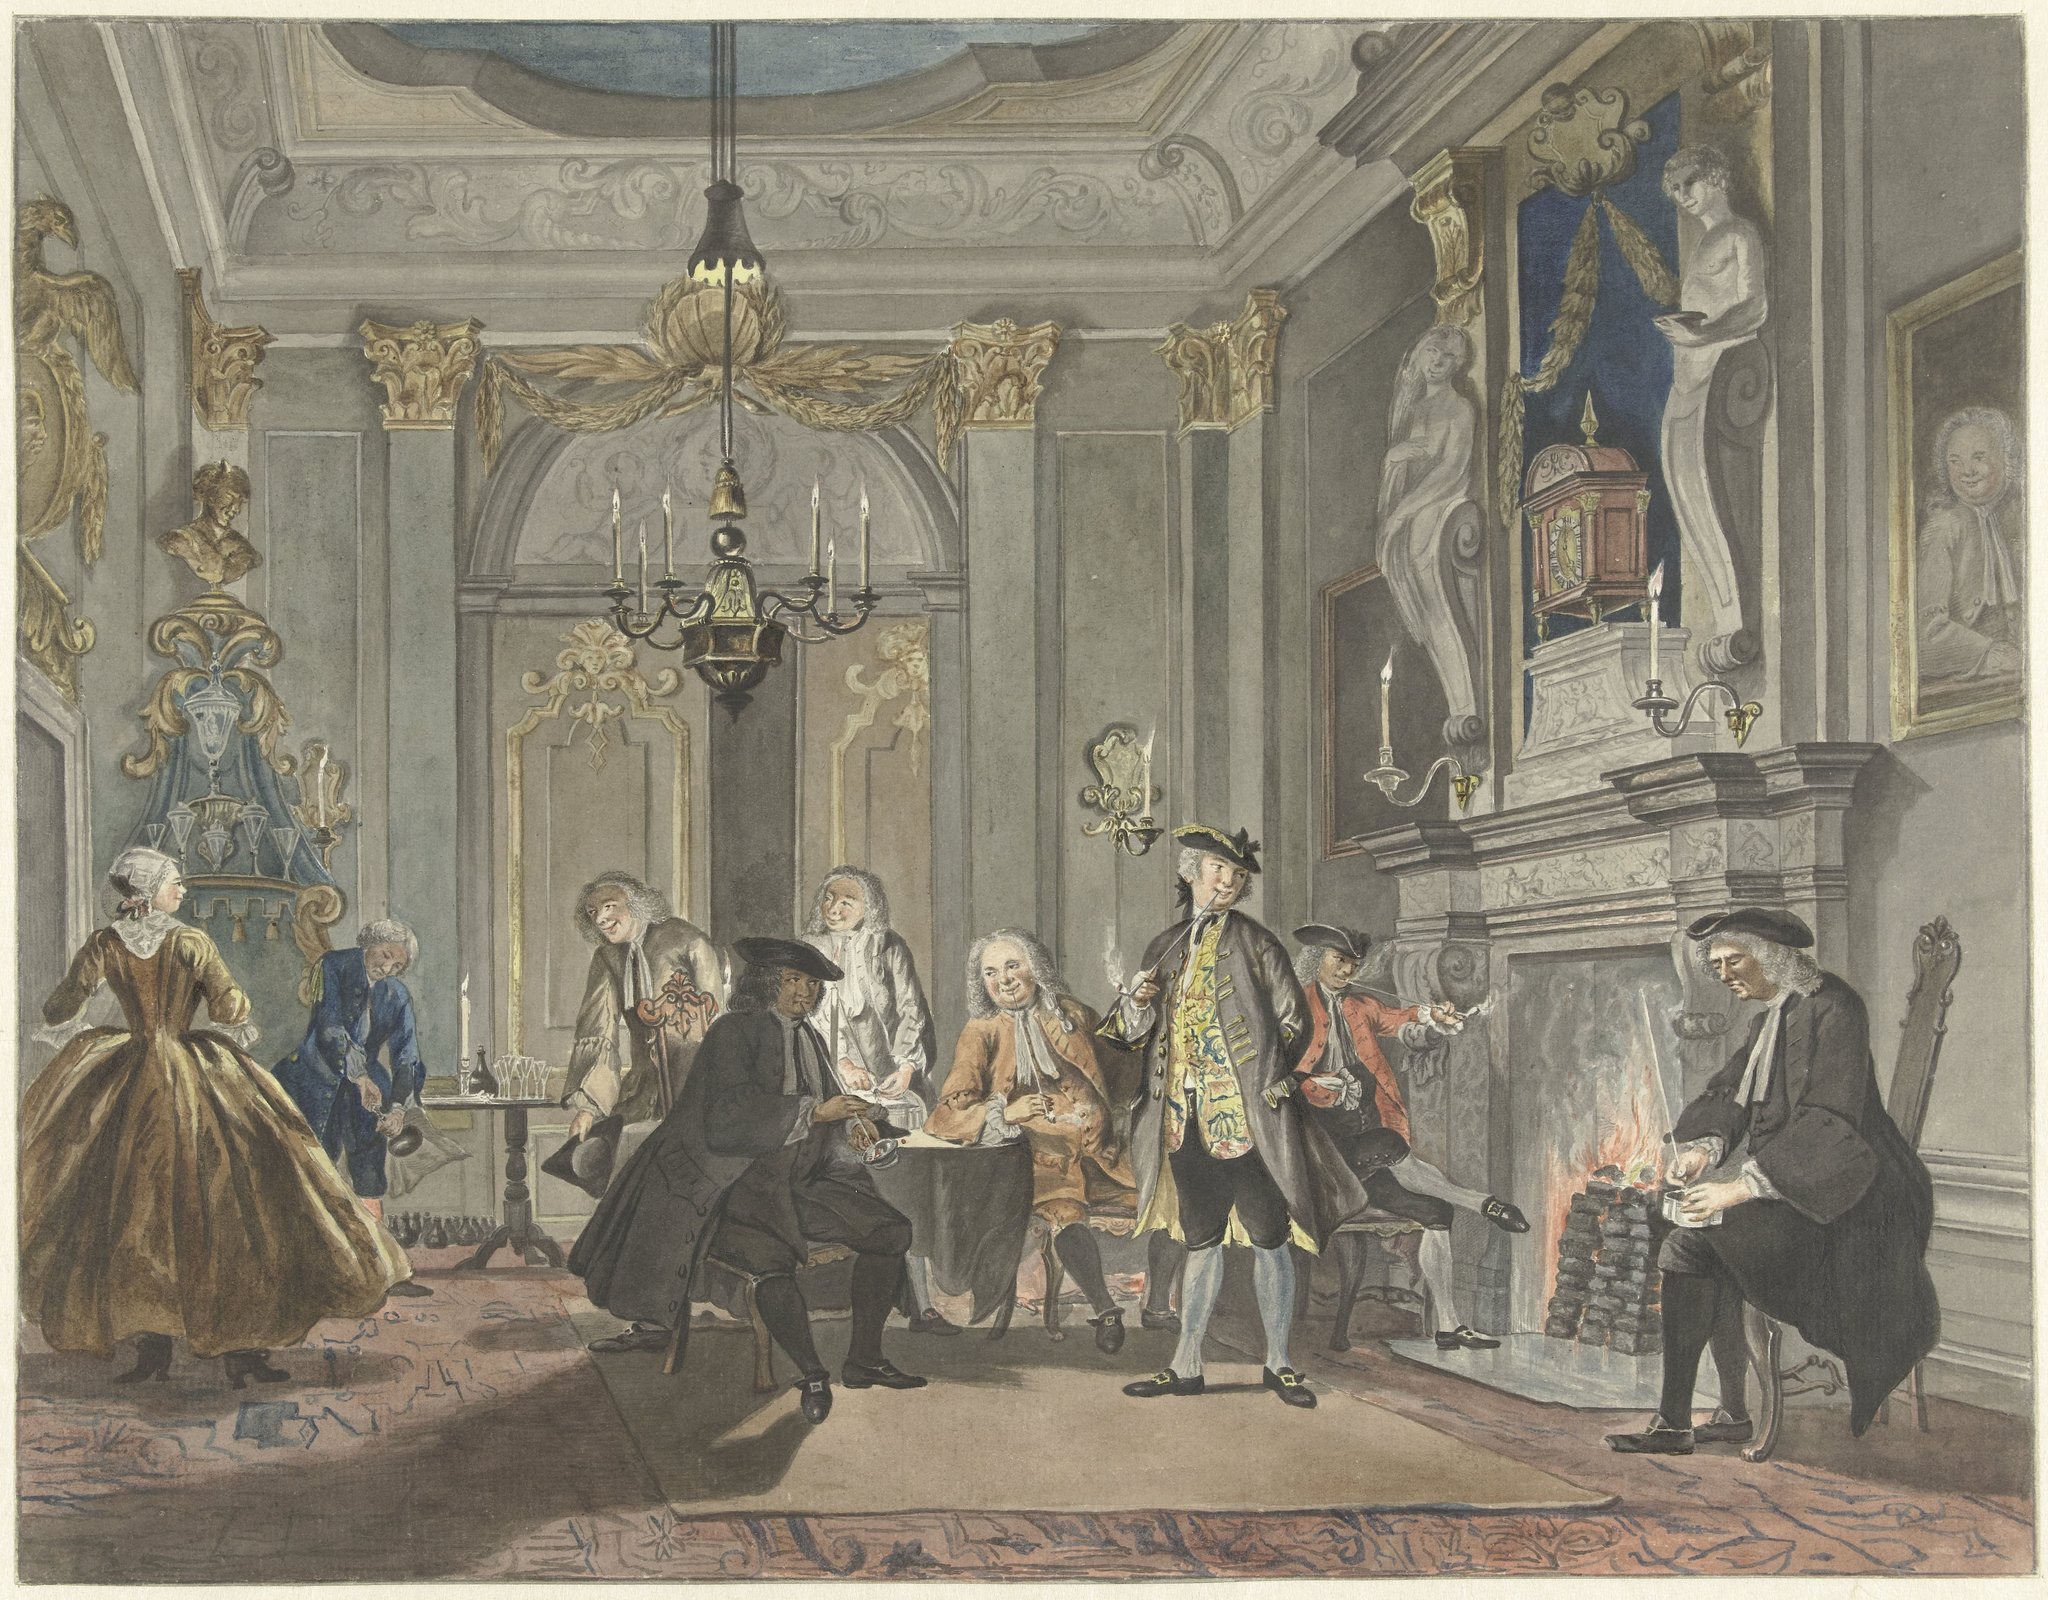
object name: drawing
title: Niemand sprak er (Nemo Loquebatur)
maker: abraham delfos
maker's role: draughtsman, painter, print maker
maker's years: 1731-1820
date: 1741-1820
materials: ink, paper, pencil, watercolor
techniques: brush, pen